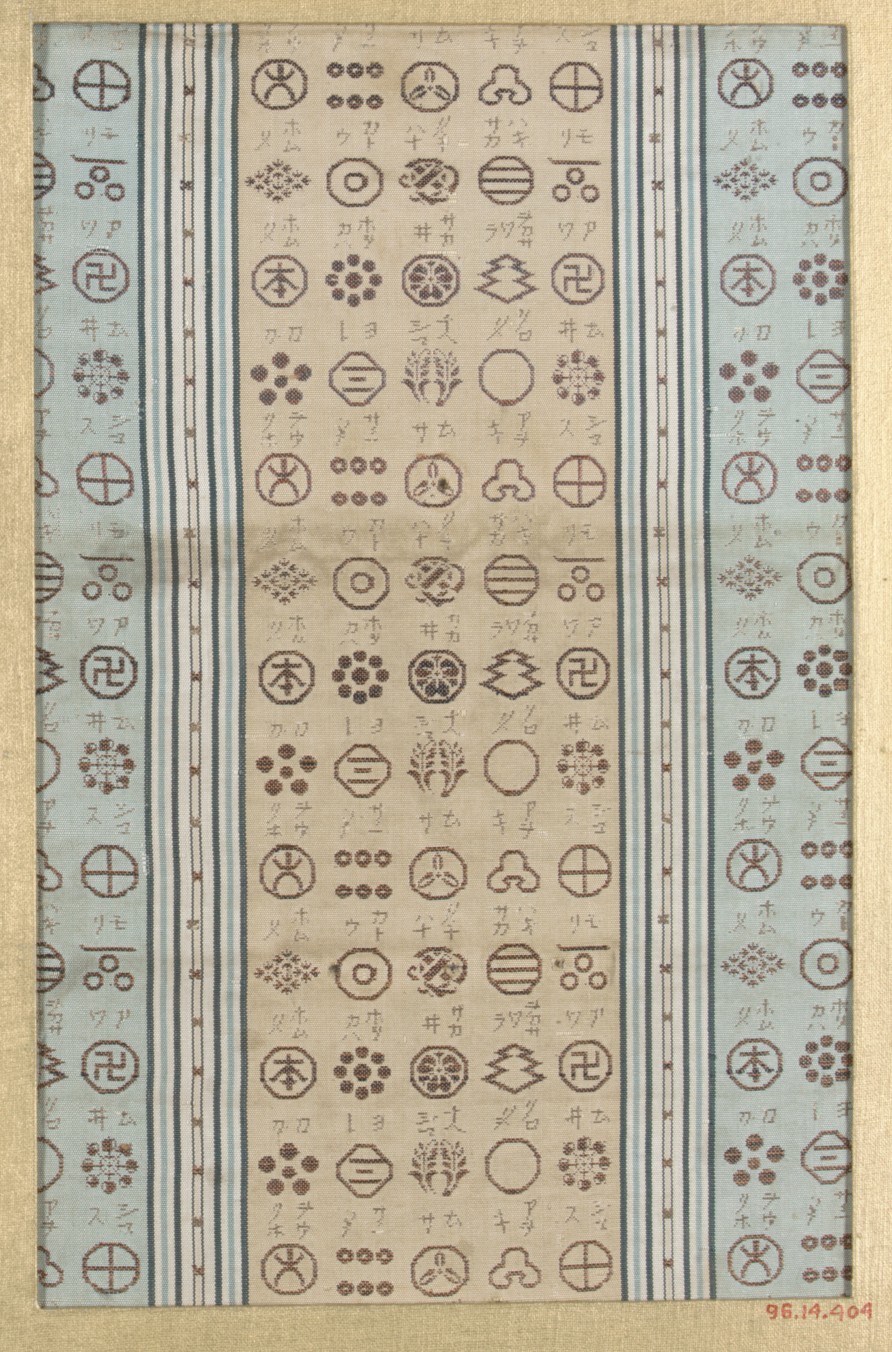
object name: piece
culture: japanese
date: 1701-1900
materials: silk